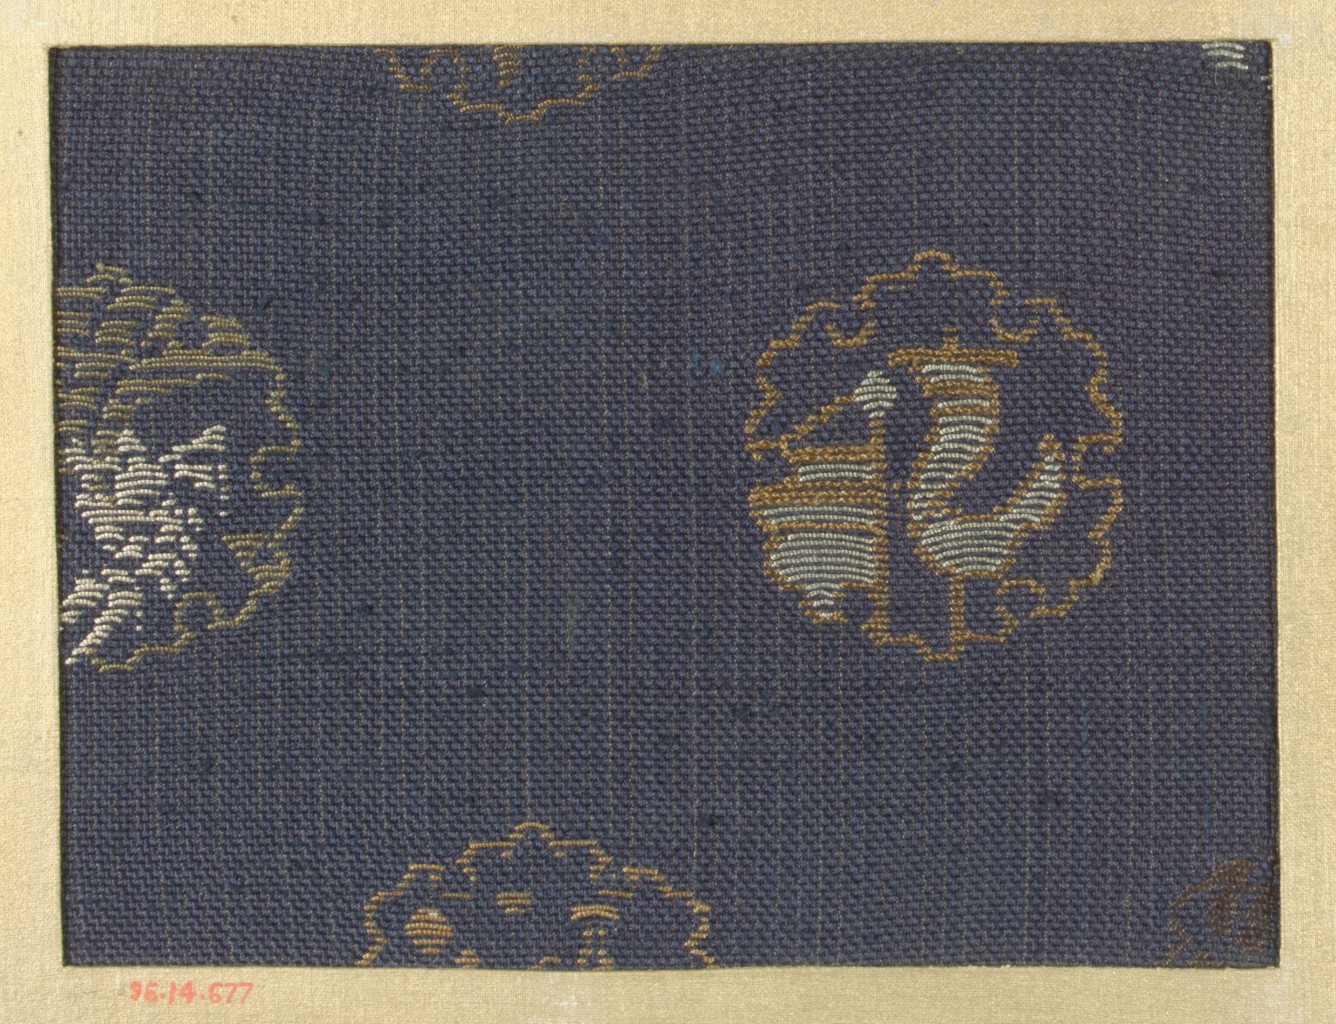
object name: piece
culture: japanese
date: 1701-1900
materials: silk